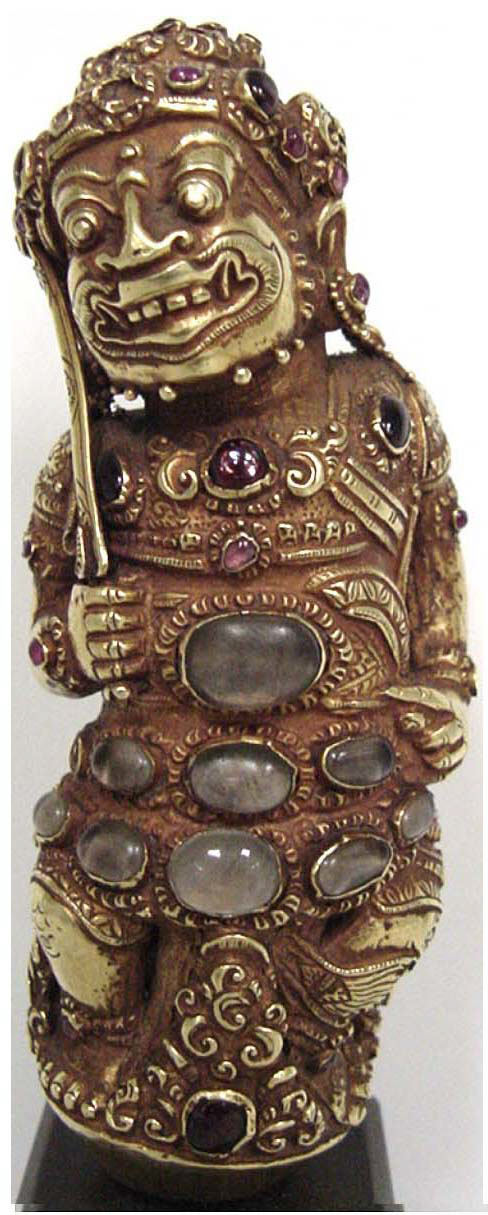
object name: dagger handle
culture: indonesian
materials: crystal, gold, stone, wood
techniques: chasing, engraving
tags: daggers,hilts,hinduism